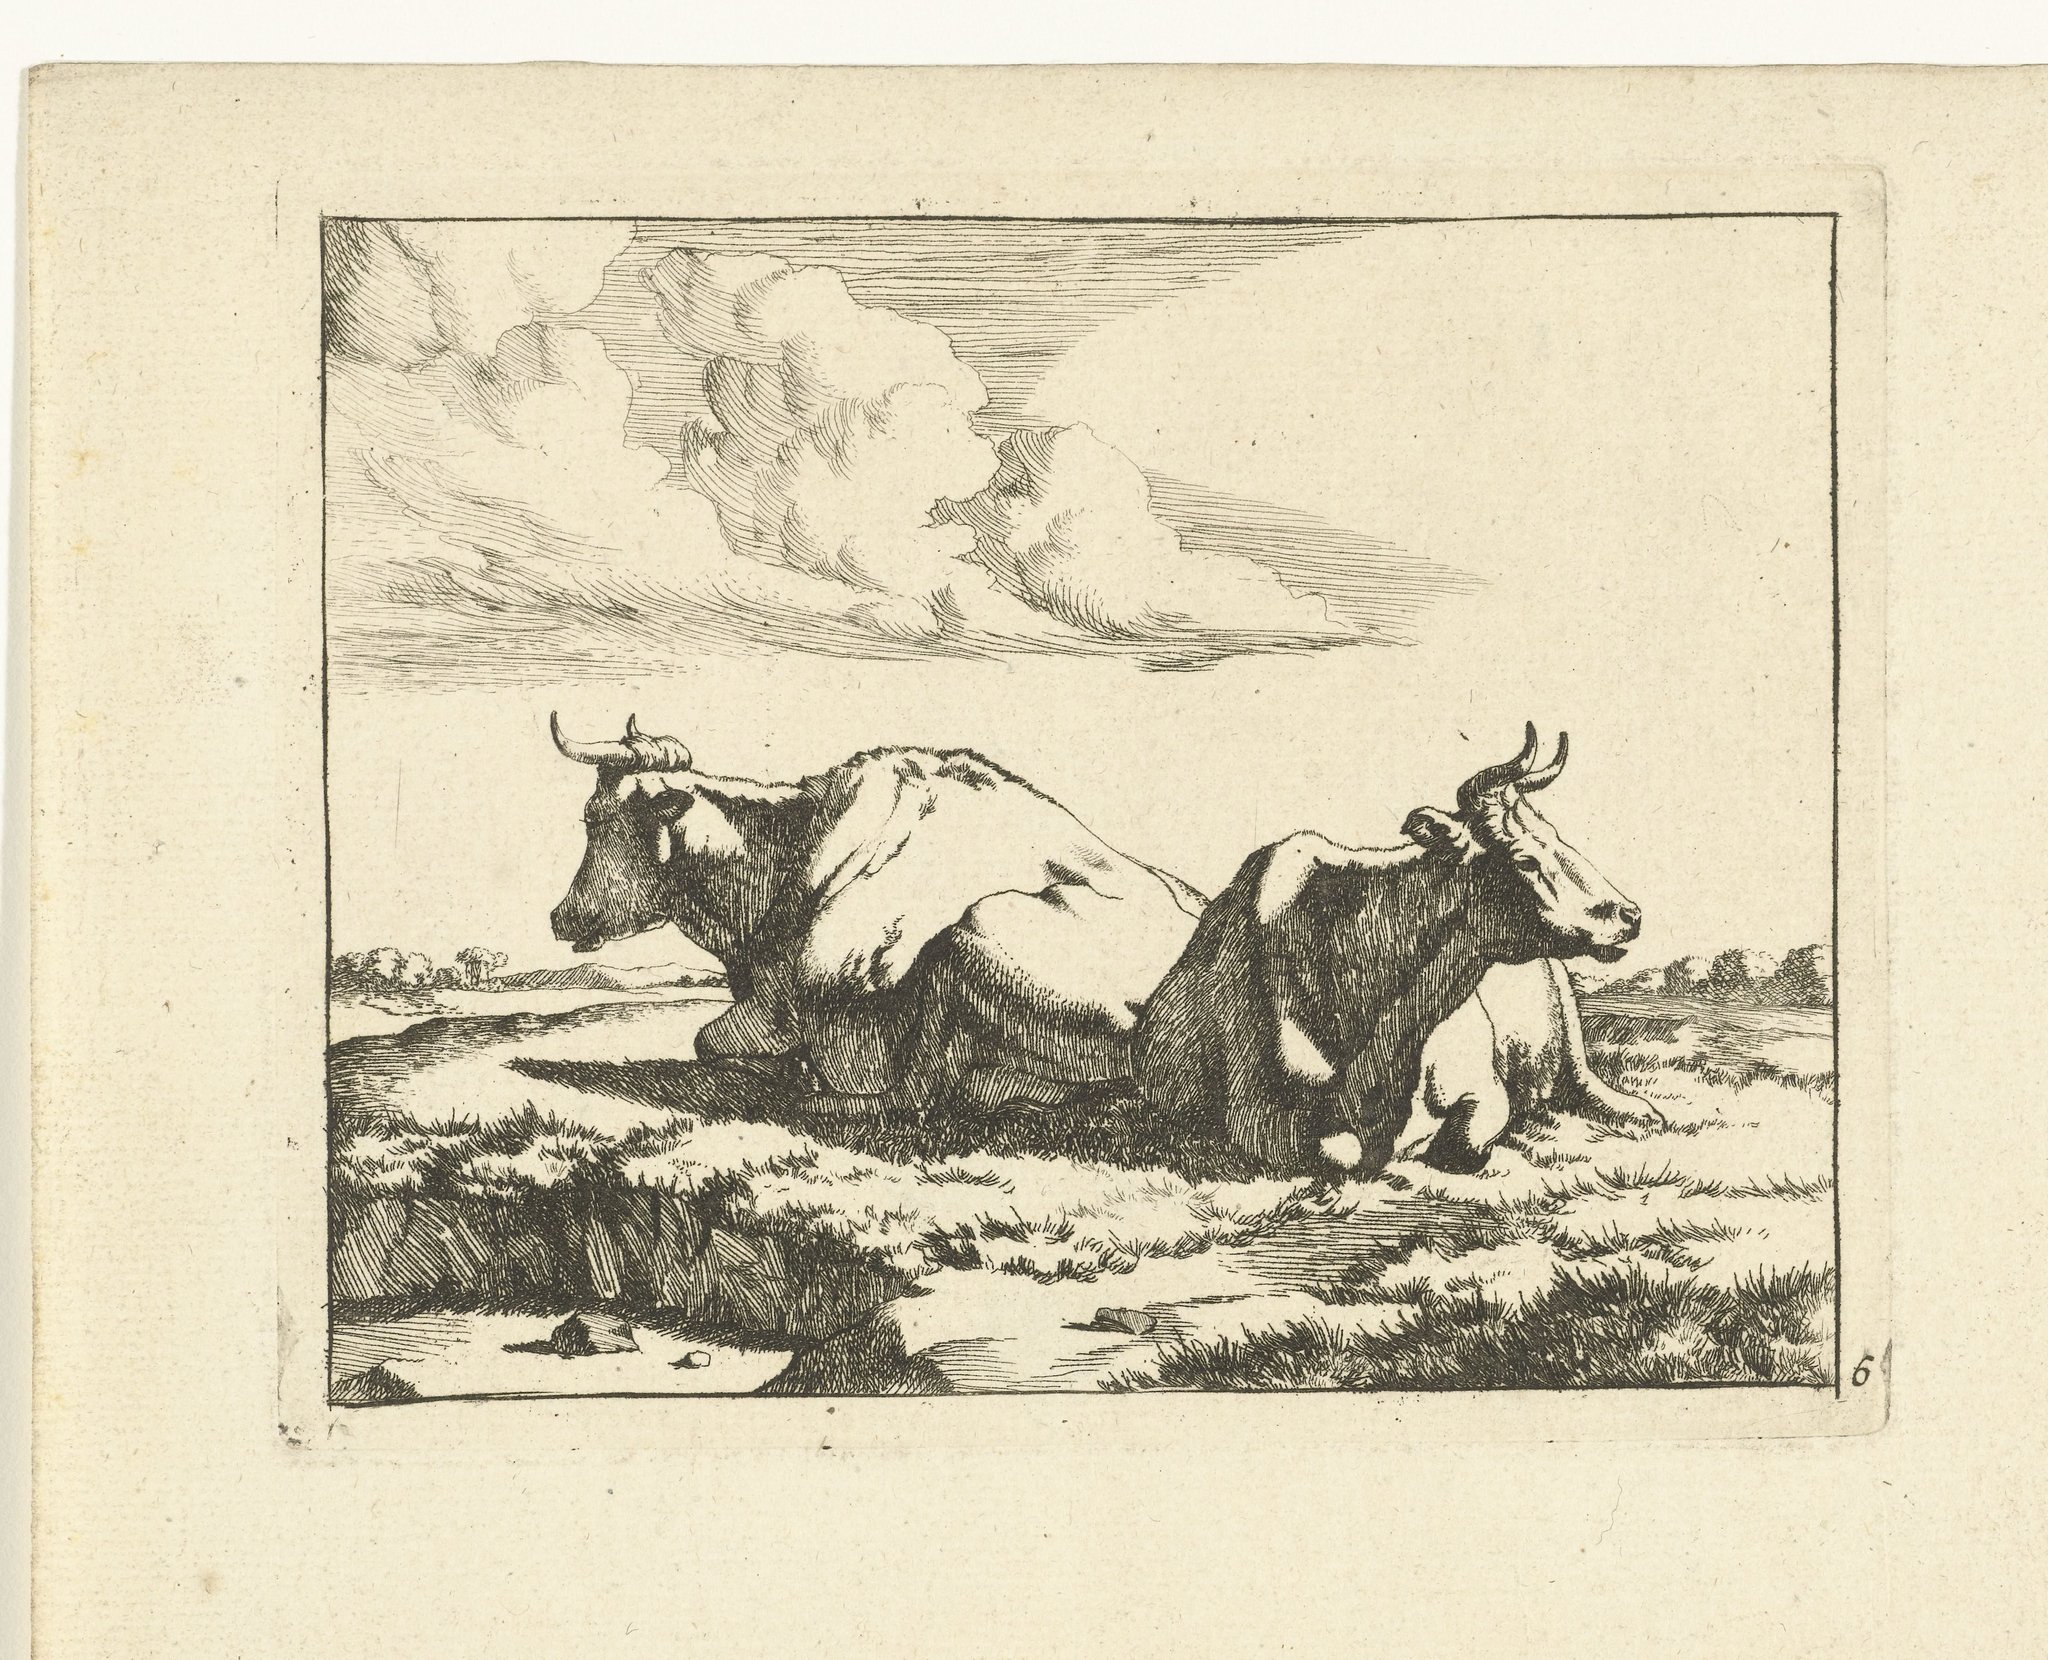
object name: print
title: Koeien en schapen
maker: marcus de bye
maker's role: print maker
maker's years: 1639-1688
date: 1657-1677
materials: paper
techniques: etching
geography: the hague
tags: cow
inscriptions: collector's mark: Lugt 2166